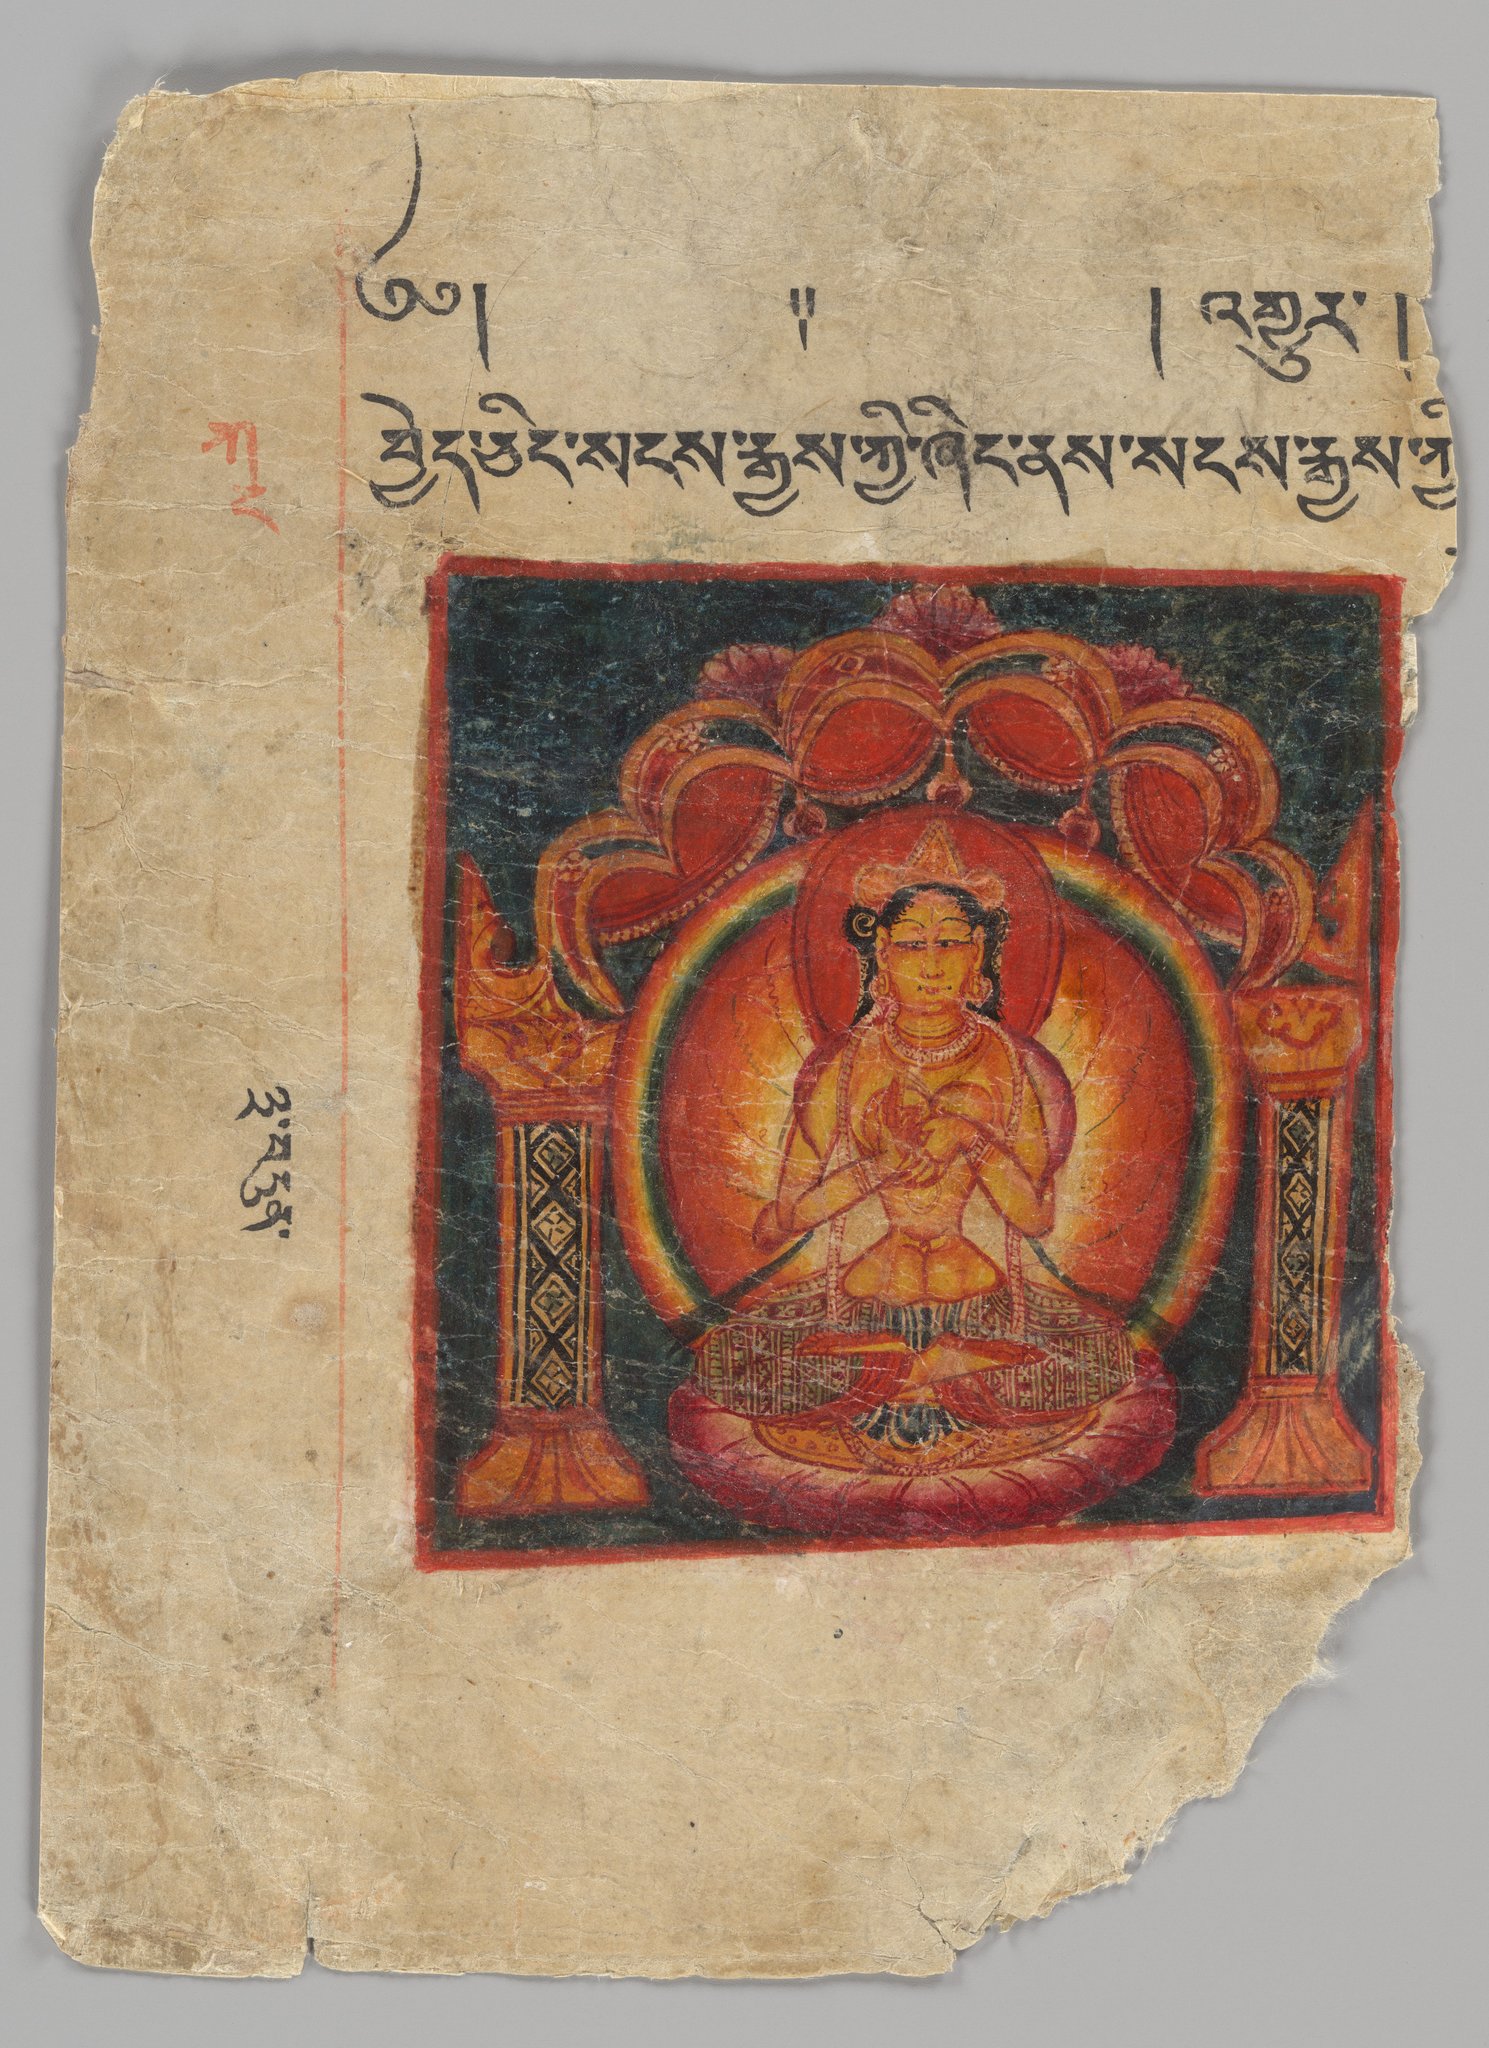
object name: manuscript fragment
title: Fragment of a Prajnaparamita Sutra manuscript folio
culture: kashmiri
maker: unidentified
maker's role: artist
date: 1001-1200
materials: ink, paper